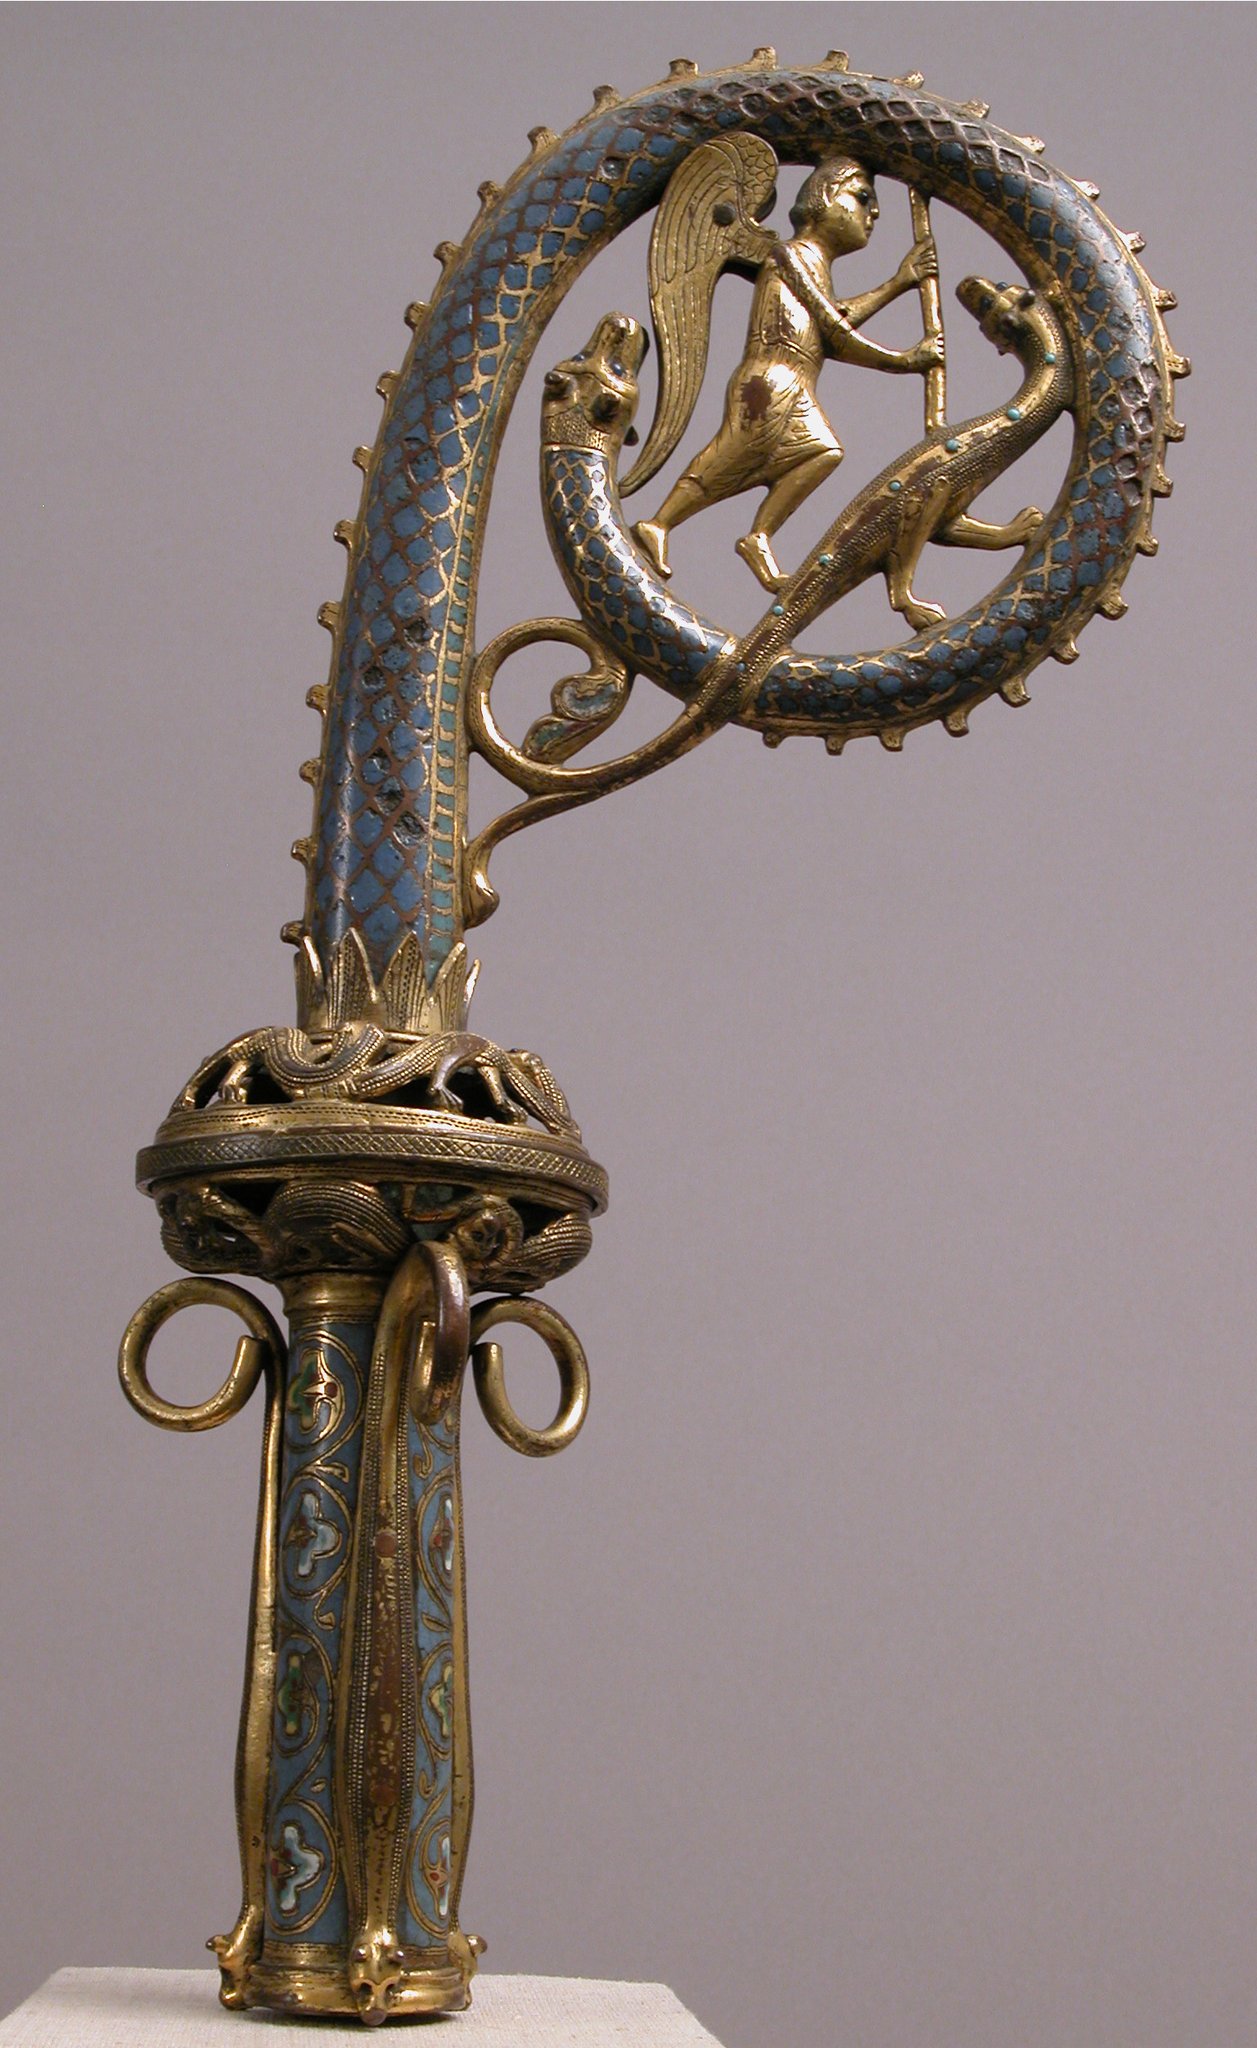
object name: crozier head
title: Crozier Head with Saint Michael Slaying the Dragon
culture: french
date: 1220-1230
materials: copper, enamel, gilt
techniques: enamel, chasing, engraving, forming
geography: france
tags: saint michael,croziers